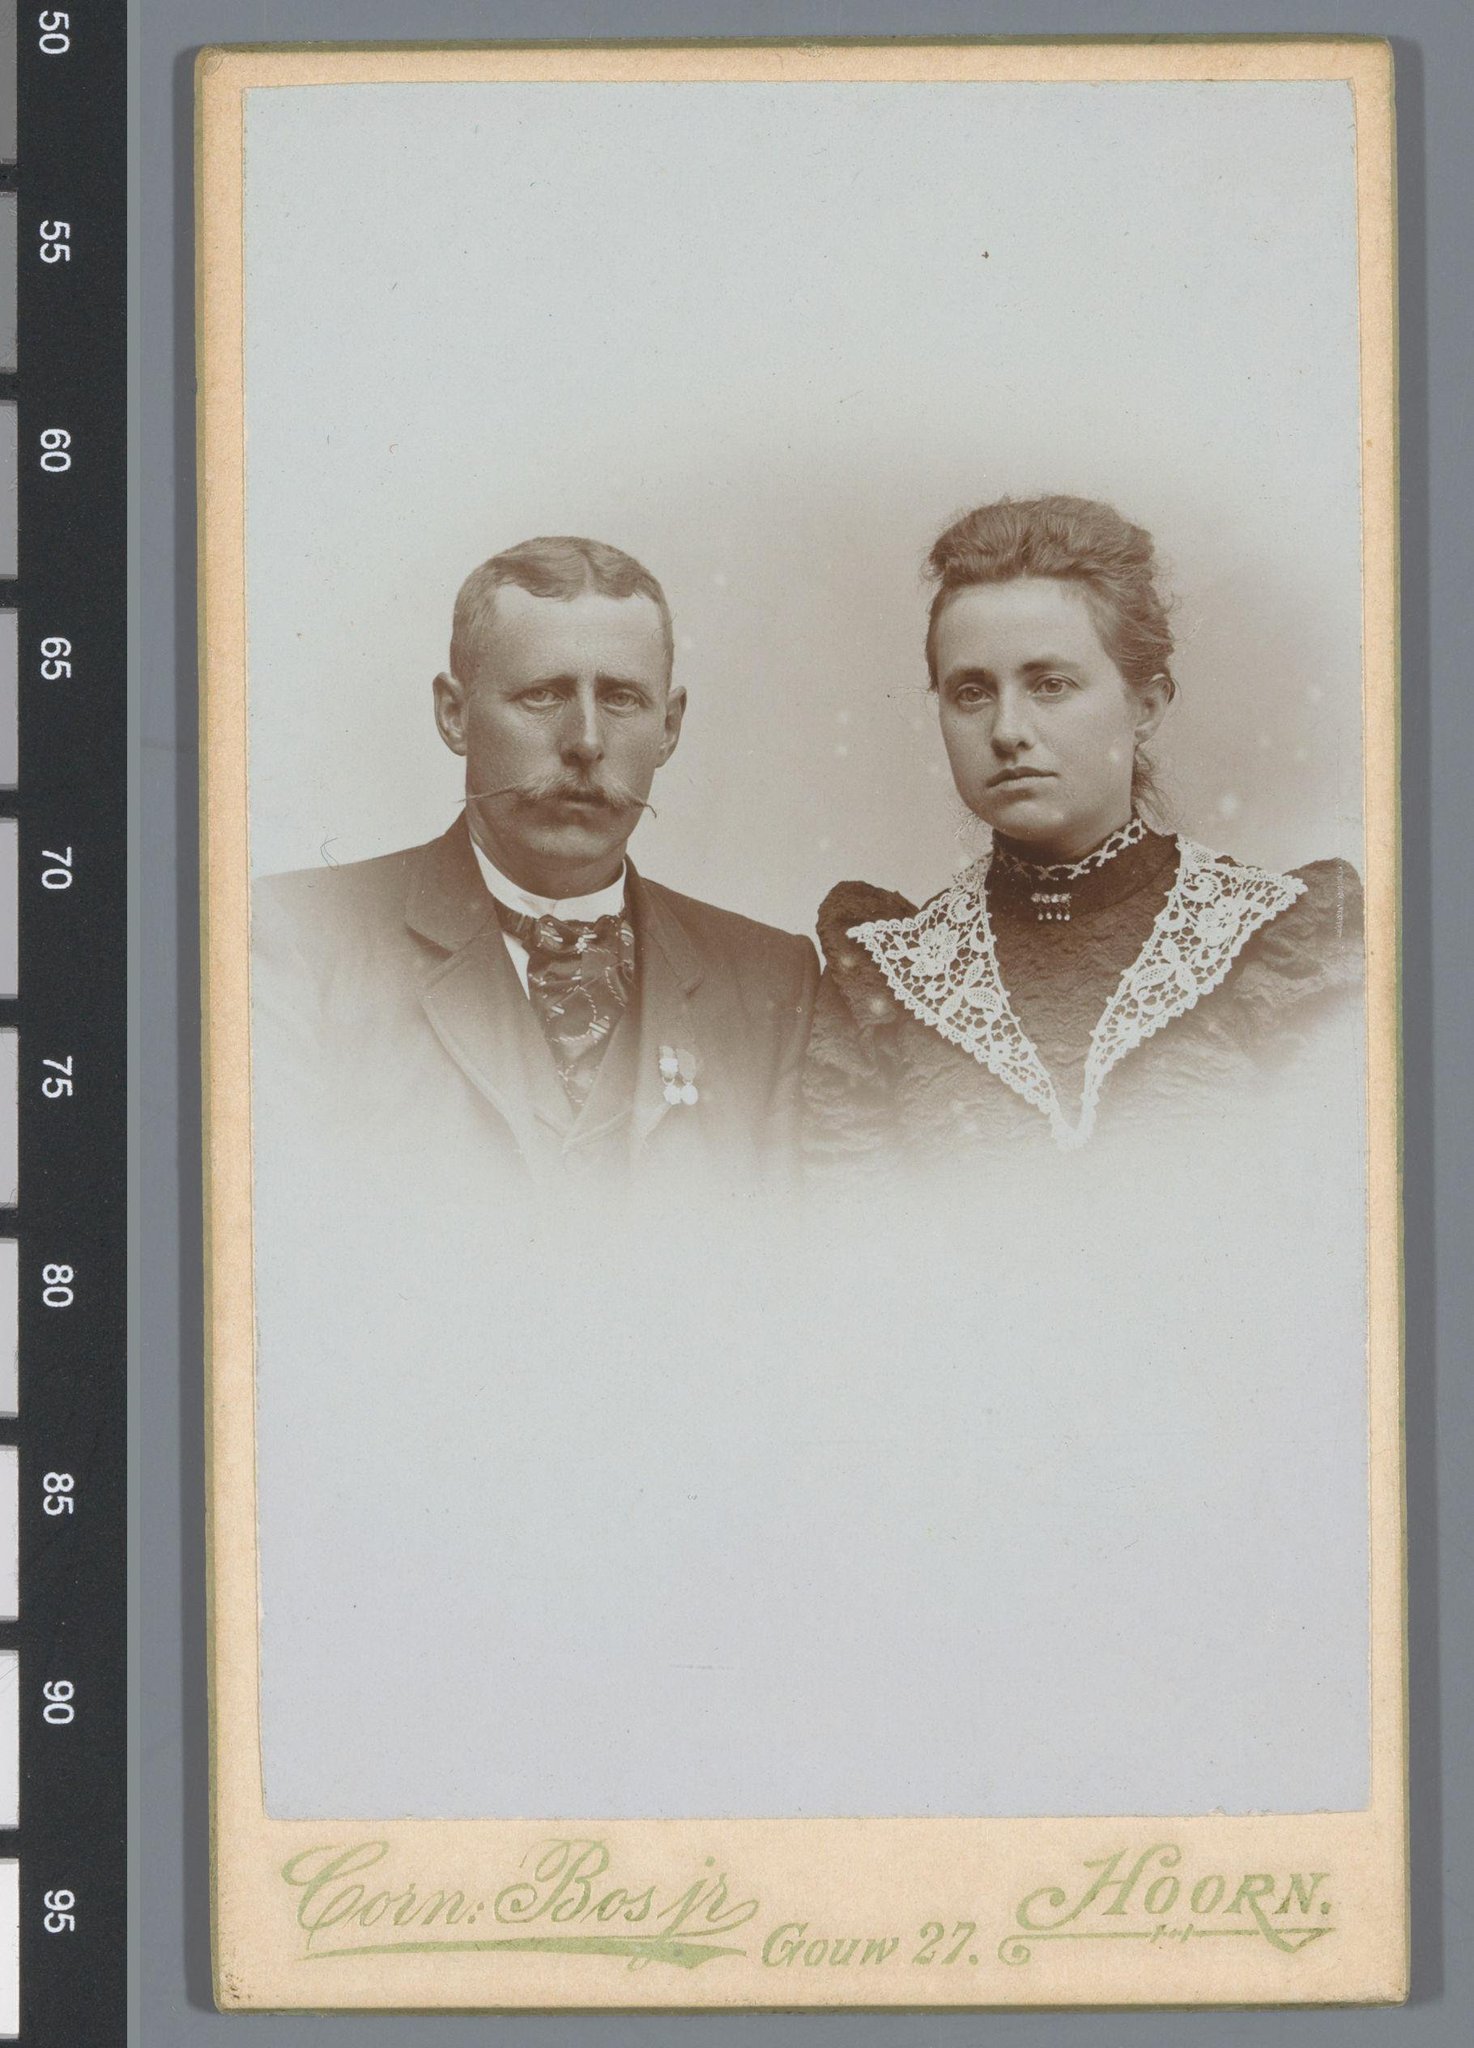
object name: carte de visite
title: Portret van Jacob Hartog en Grietje Groot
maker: cornelis bos jr.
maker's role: fotograaf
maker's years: 1869-1953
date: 1898-1920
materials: cardboard, photographic support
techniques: collodion silver print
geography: hoorn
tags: adult woman, adult man, historical persons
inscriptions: inscription: ‘Jacob Hartog/ Grietje Groot’, address: ‘Corn: Bos jr/ Gouw 27./ HOORN.’